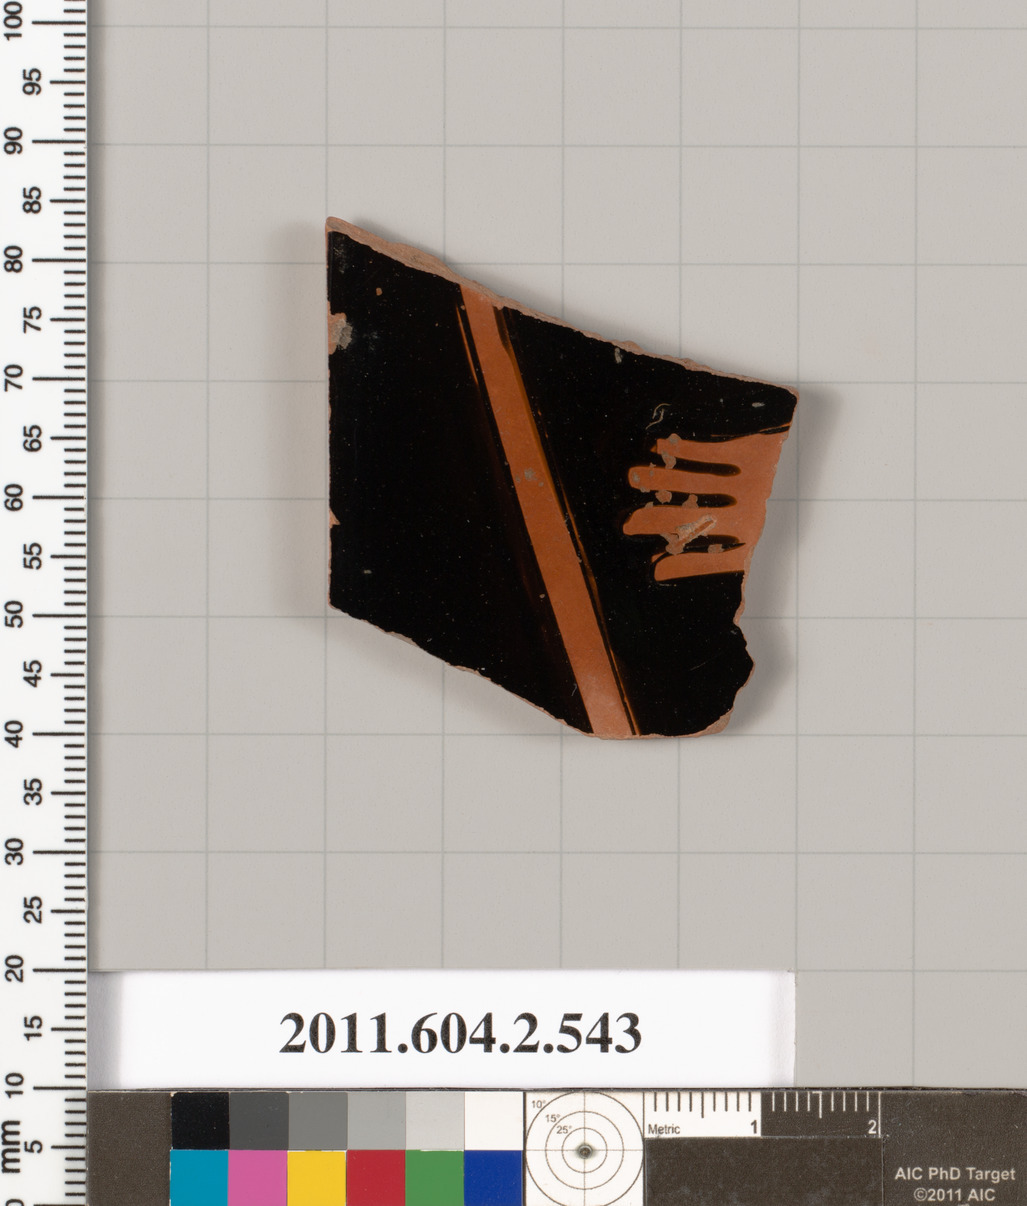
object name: column krater fragment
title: Terracotta fragment of a column-krater (bowl for mixing wine and water)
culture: greek, attic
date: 460-440 BCE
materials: terracotta